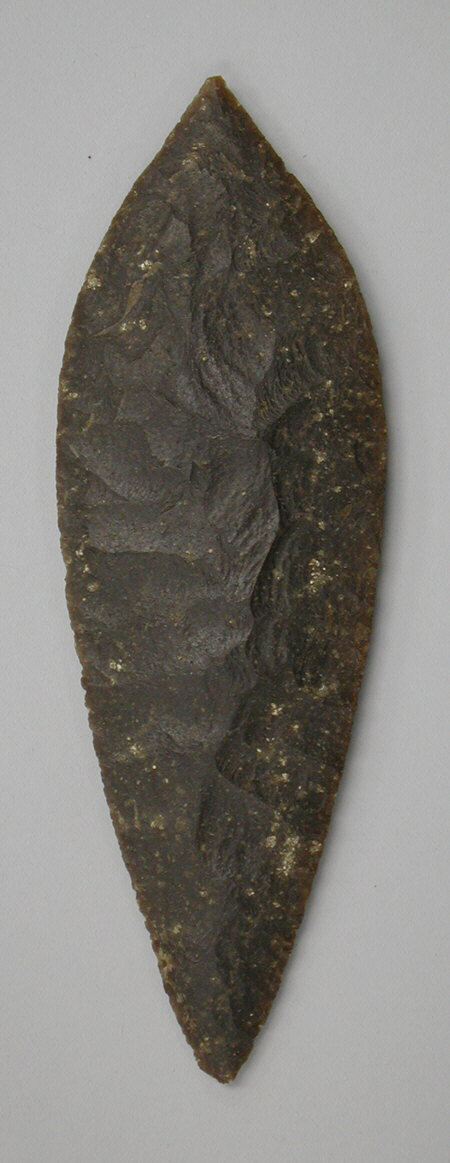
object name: knife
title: Flint Blade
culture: mexican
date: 1501-1600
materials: stone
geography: mexico